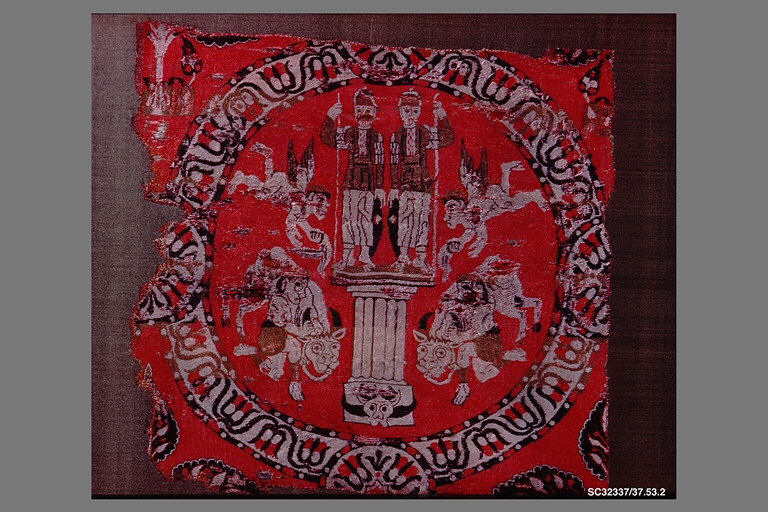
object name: textile fragment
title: Textile Fragment: Offering to the Dioscuri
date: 601-633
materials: silk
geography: syria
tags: animals,men,mythical creatures